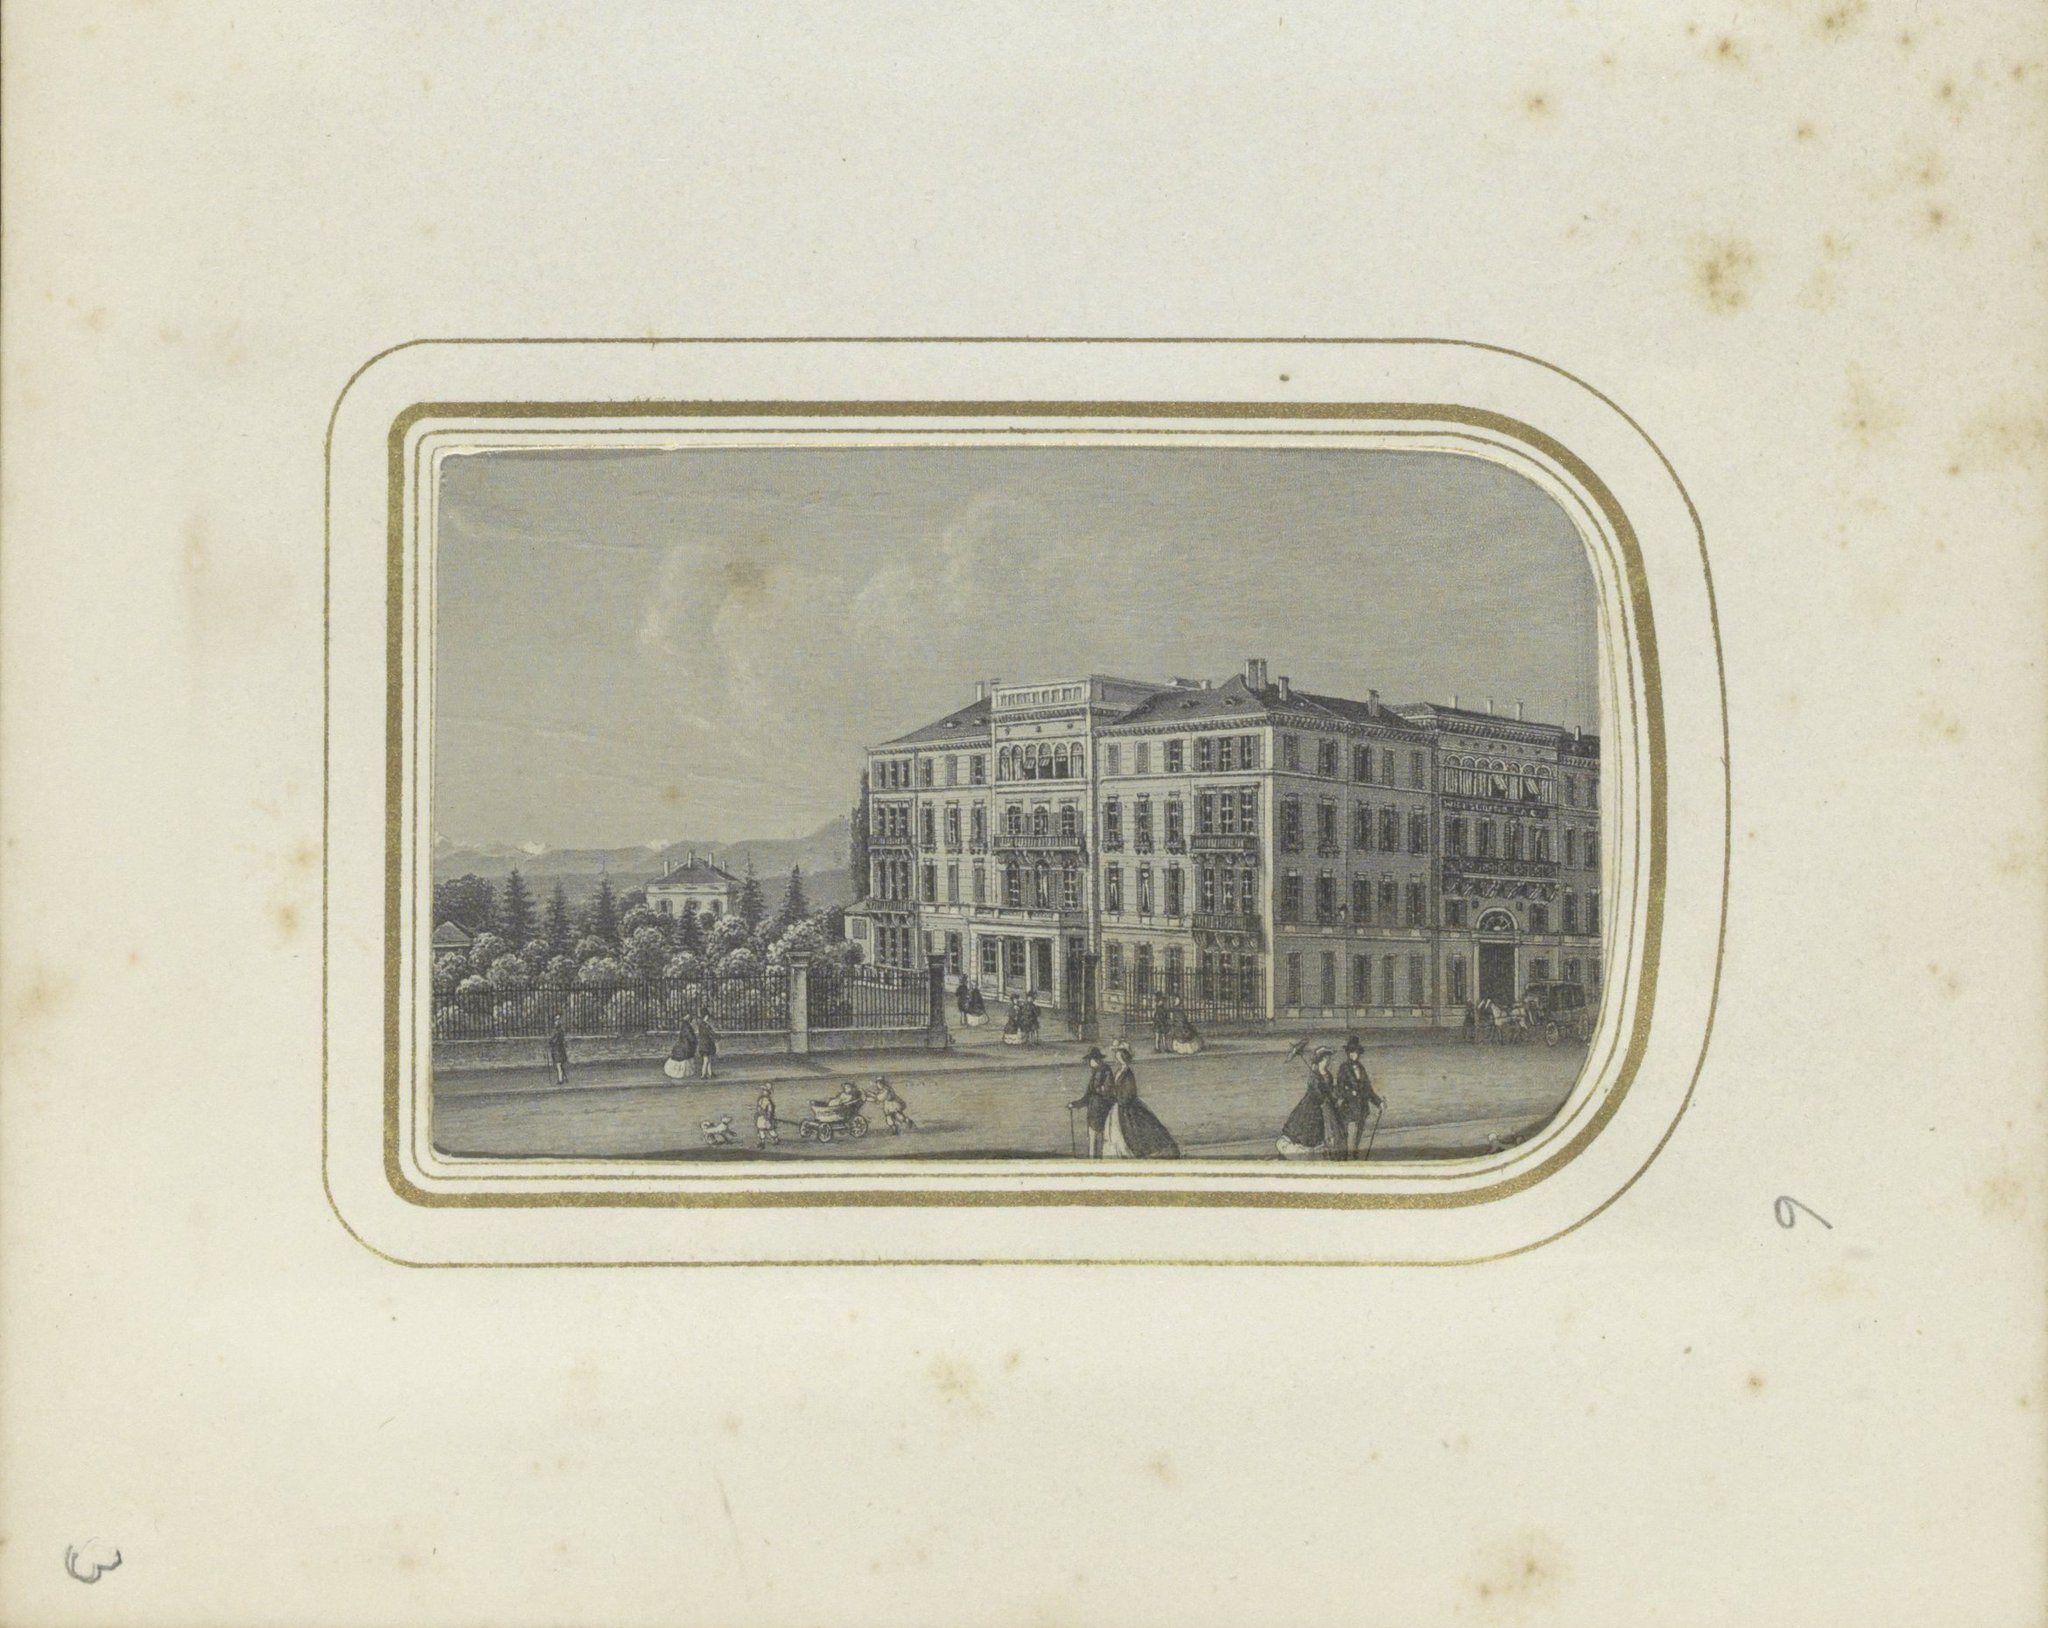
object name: print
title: Exterieur van Hotel Bauer au Lac aan de Bürkliplatz in Zürich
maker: Anonymous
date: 1864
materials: paper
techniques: aquatint, etching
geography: switzerland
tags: travelling; tourism, hotel, hostelry, inn, square, place, circus, etc. (+ city(-scape) with figures, staffage)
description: Onderdeel van Fotoalbum van een reis door Zwitserland, Oostenrijk en Duitsland door de Nederlandse familie Derkinderen.